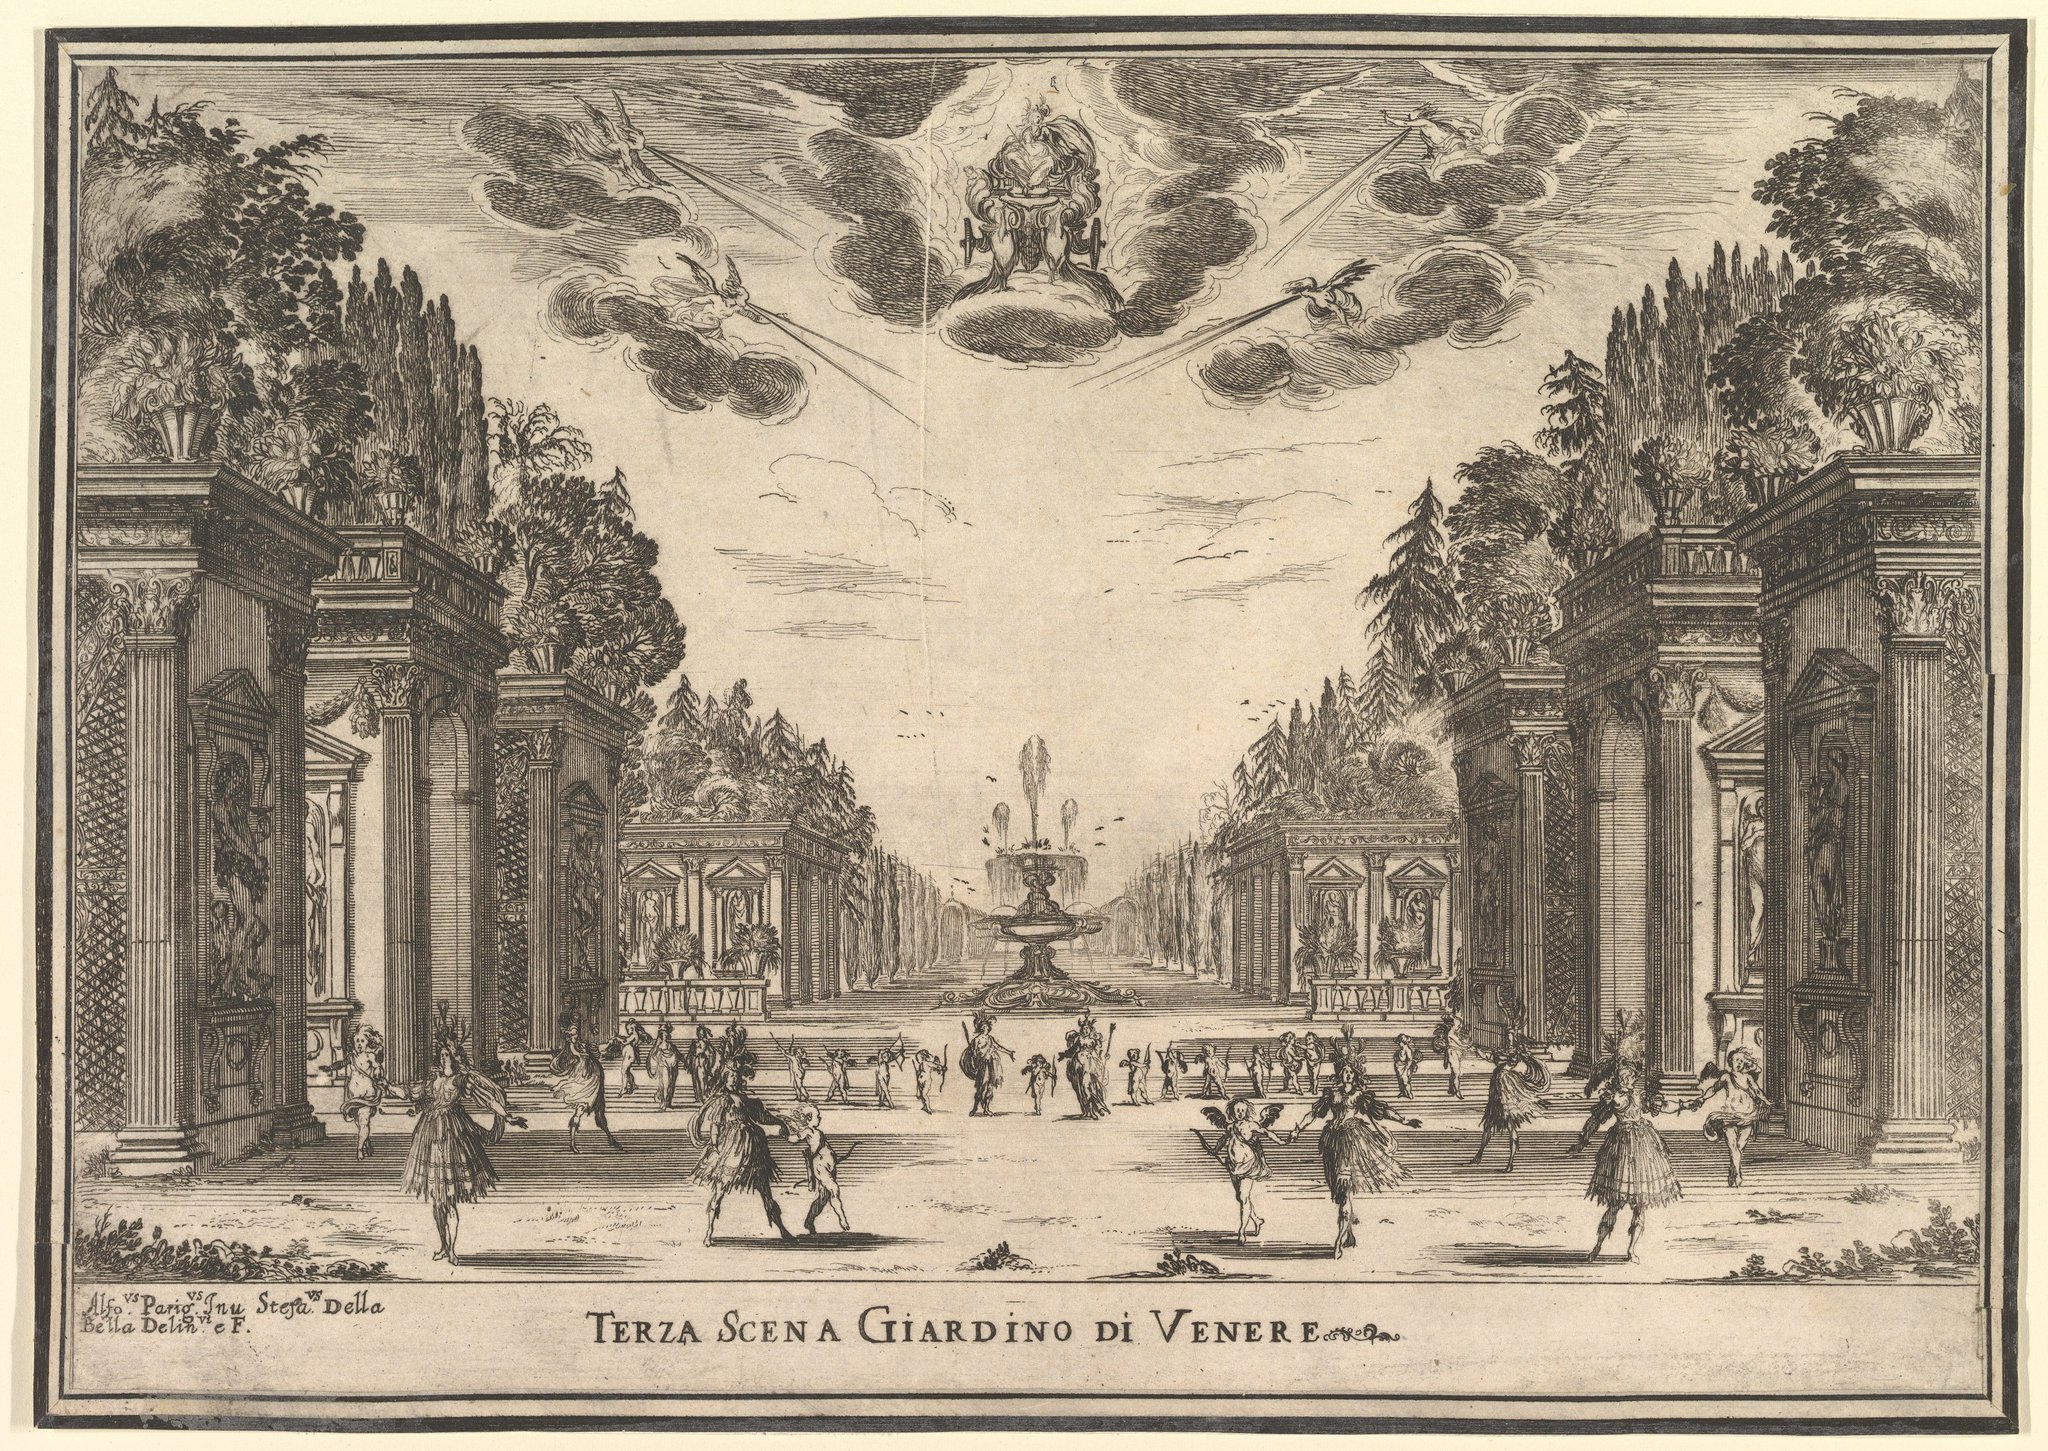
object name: print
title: Third scene, the garden of Venus, from "The marriage of the gods" (Le nozze degli Dei)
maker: stefano della bella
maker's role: artist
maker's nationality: italian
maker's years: 1610-1664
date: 1637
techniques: etching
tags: fountains,gardens